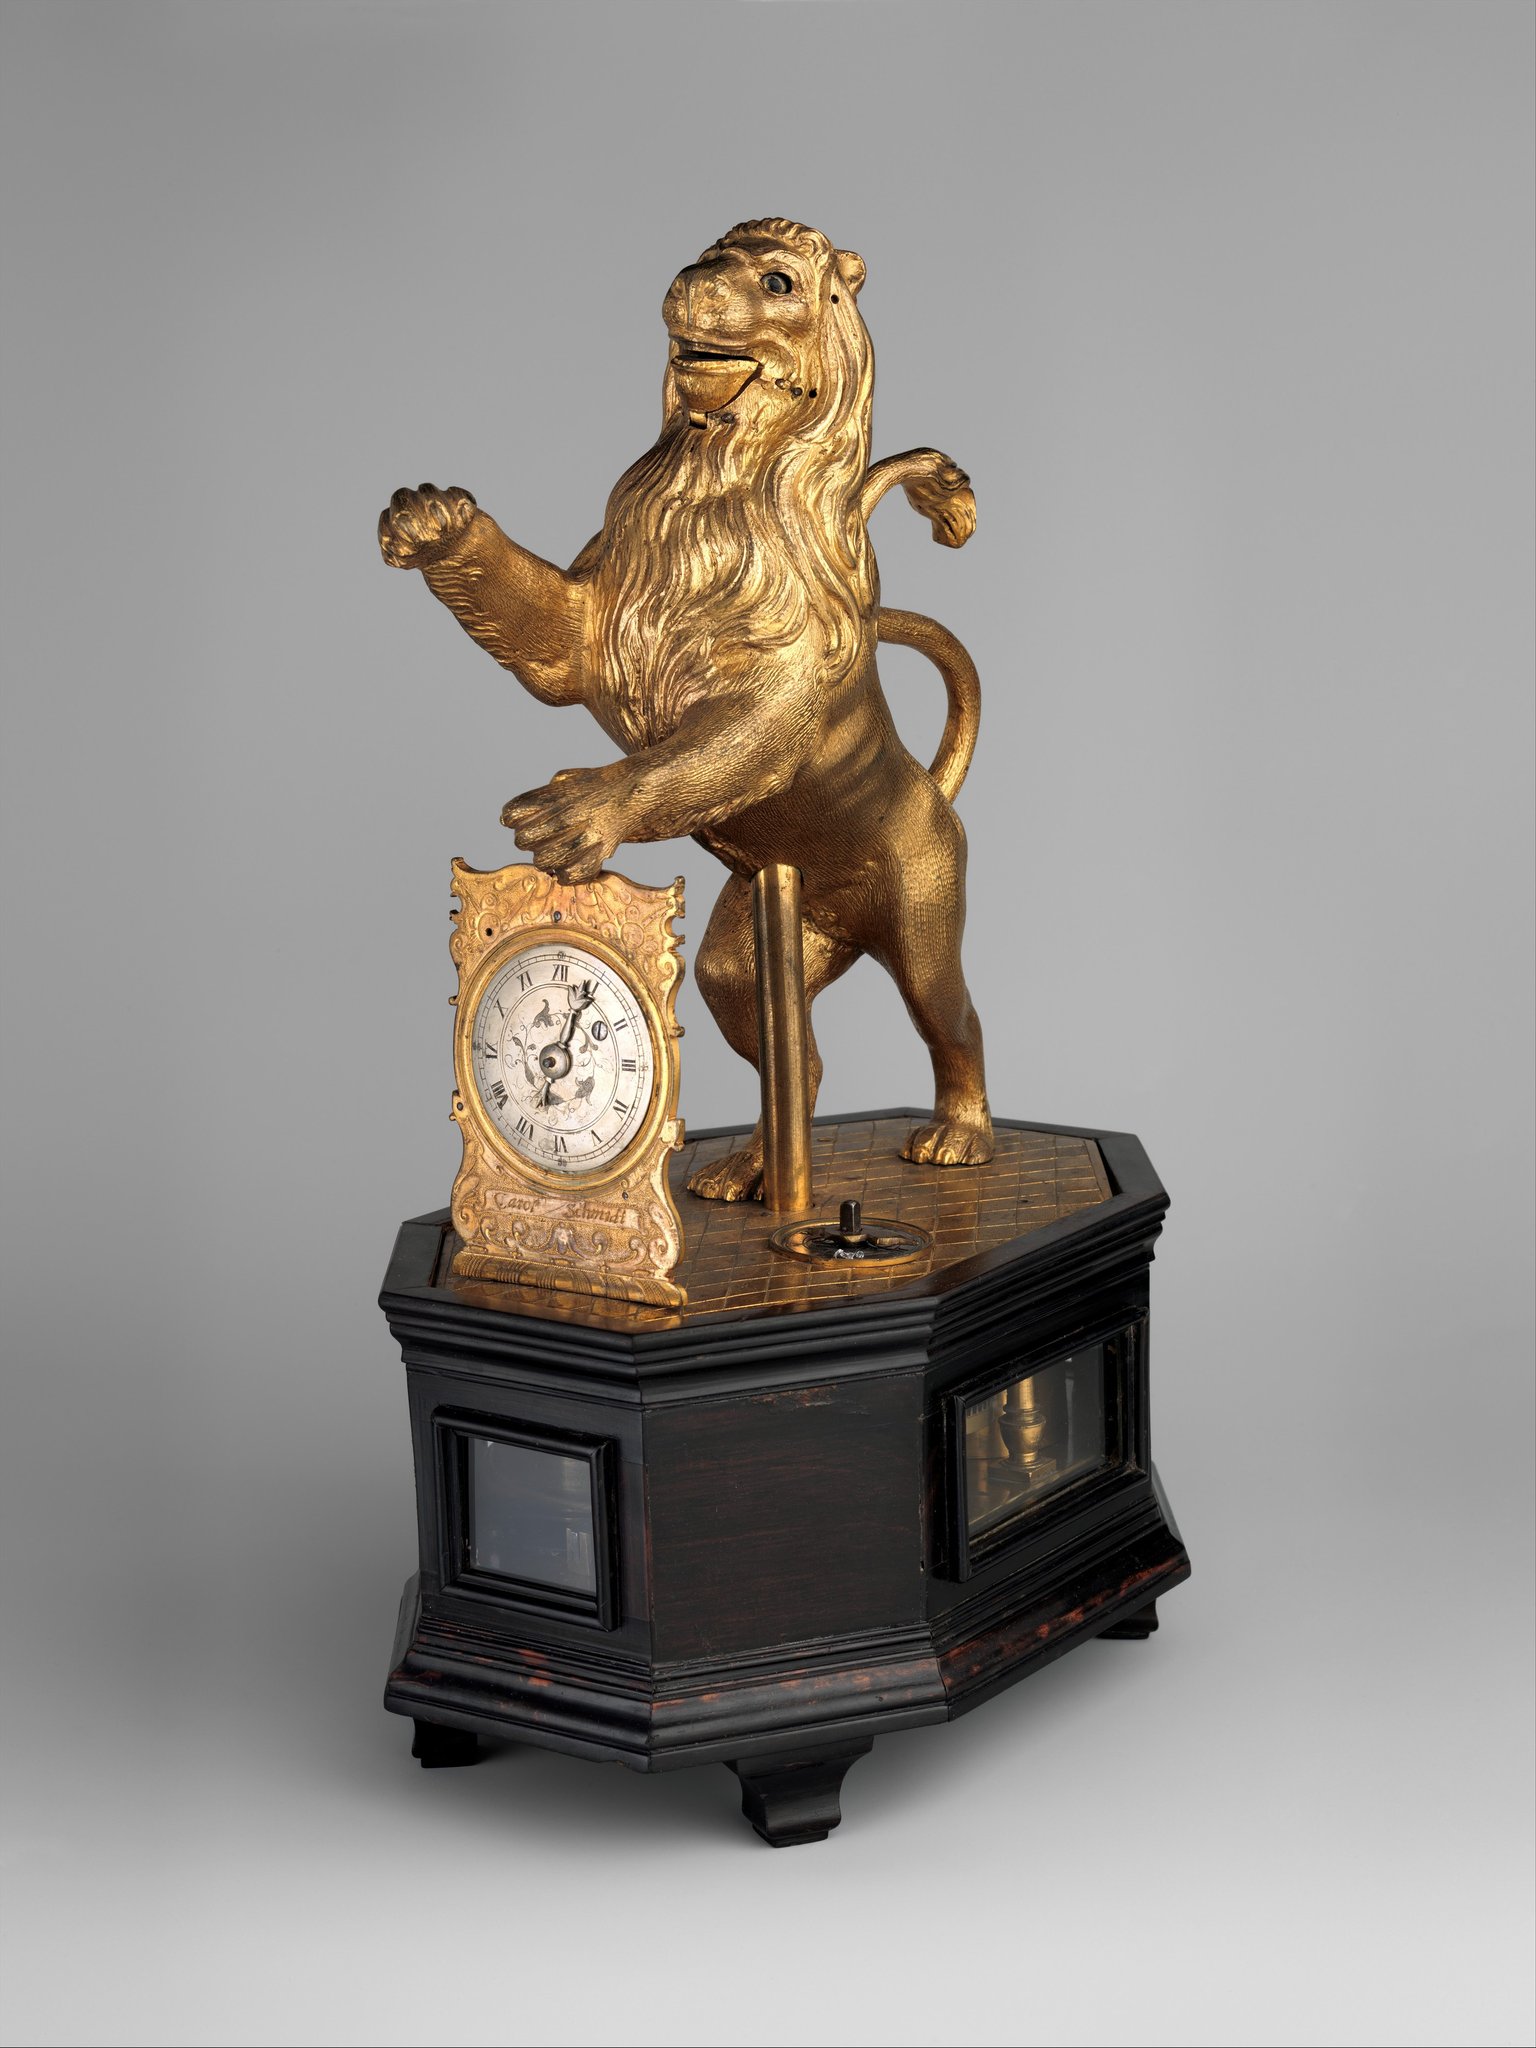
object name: automaton clock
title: Automaton clock in the form of a lion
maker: karl schmidt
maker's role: maker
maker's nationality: german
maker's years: 1590-1636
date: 1620-1635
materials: brass, wood, gilt brass, gilt silver, iron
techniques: silvered, veneering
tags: lions